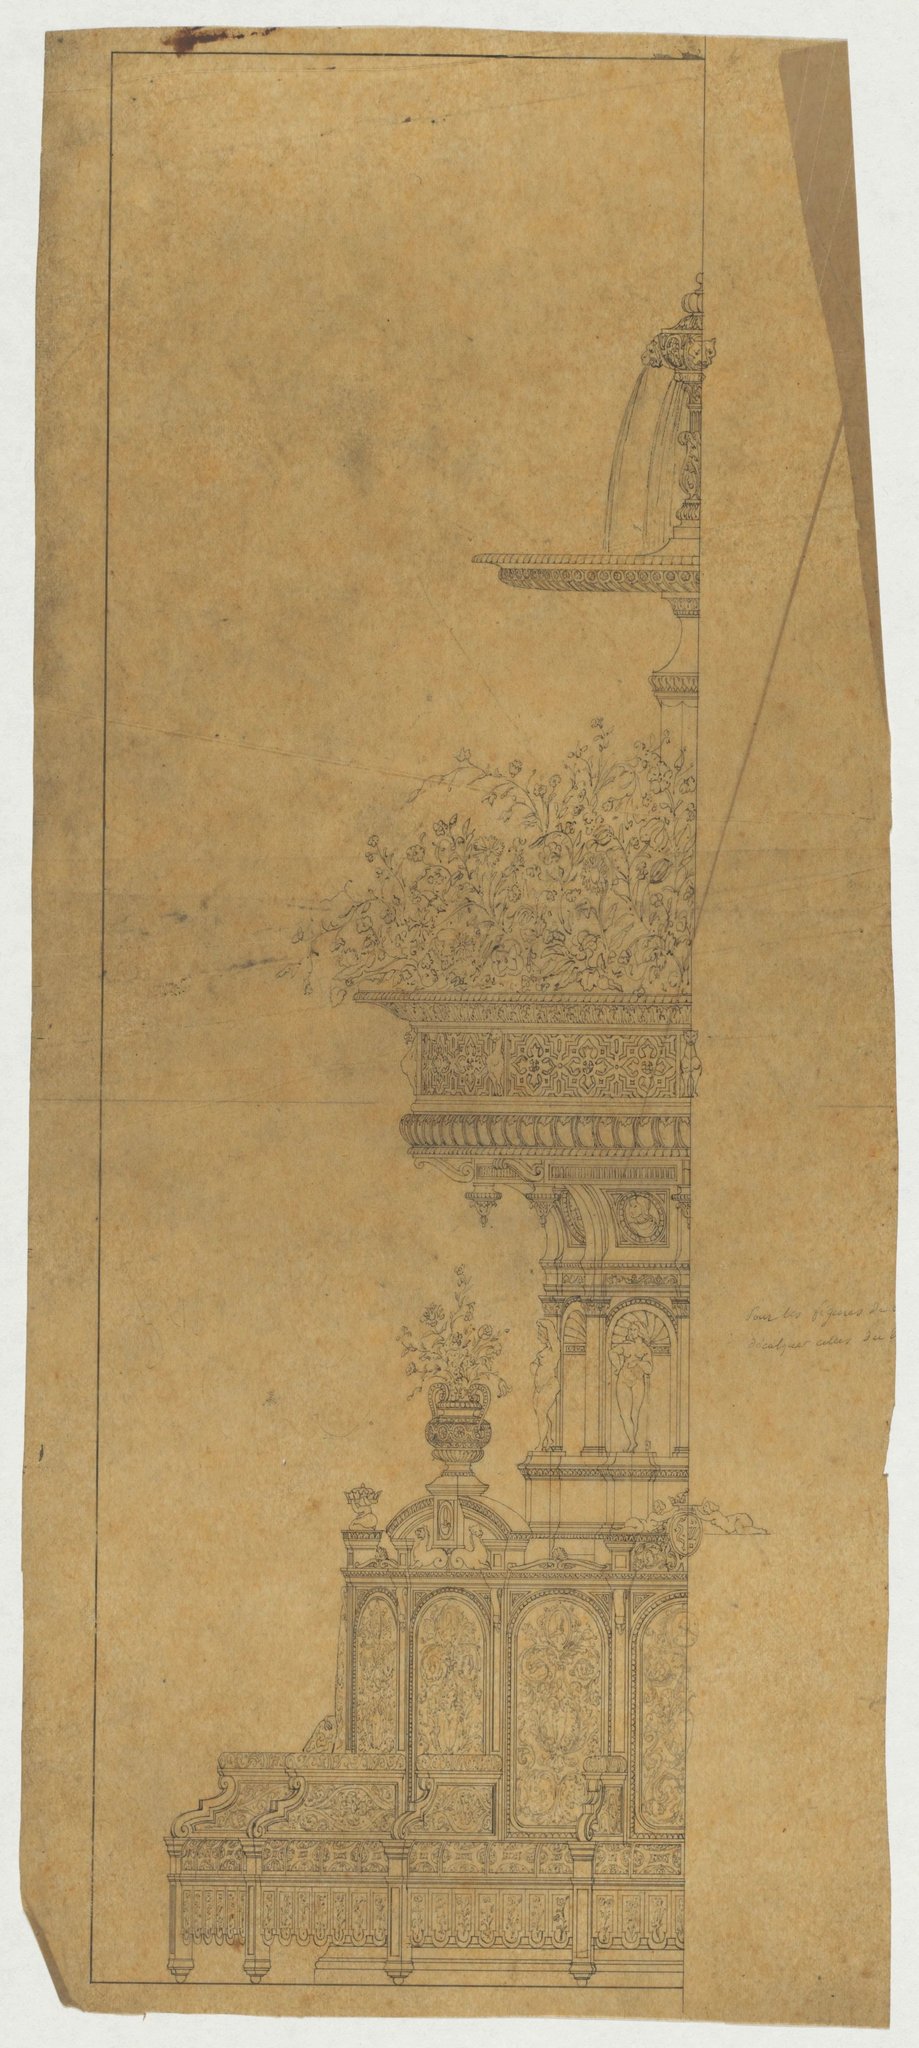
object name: design drawing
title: Tafelfontein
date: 1830-1850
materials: graphite, paper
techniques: pen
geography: paris